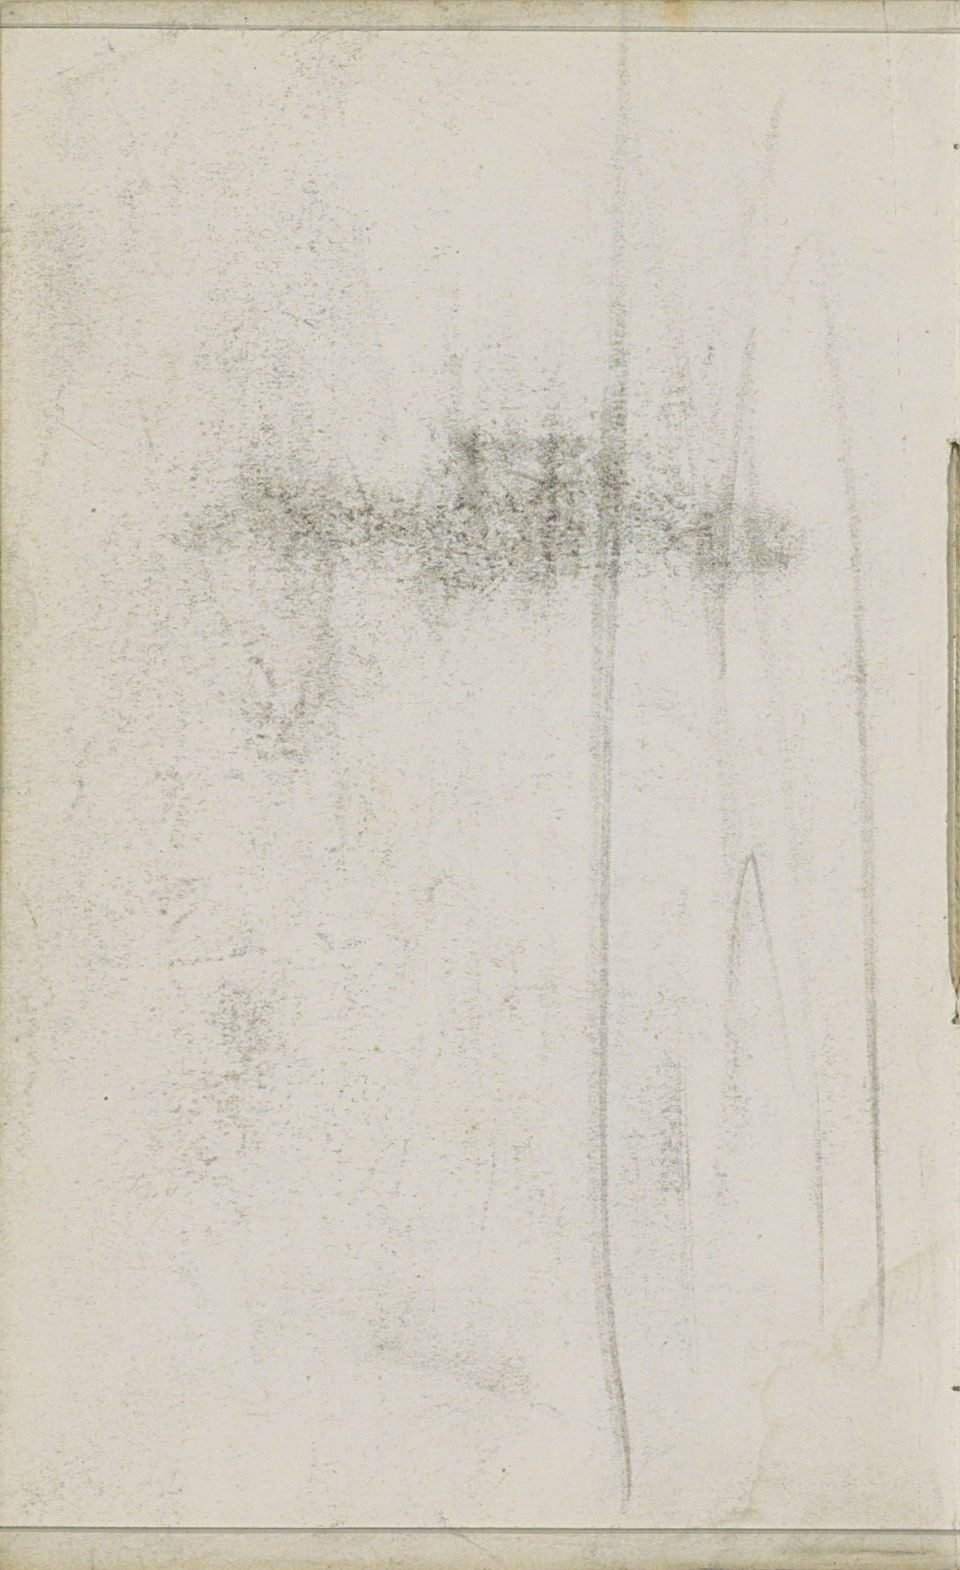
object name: sketchbook leaf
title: Abklatsch van een krijttekening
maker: anton mauve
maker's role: draughtsman, painter, print maker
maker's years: 1838-1888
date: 1848-1888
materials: paper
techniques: printmaking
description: De tekening, vermoedelijk van een figuur, is niet langer aanwezig in het schetsboek. Blad 12 verso uit een schetsboek met 53 bladen.